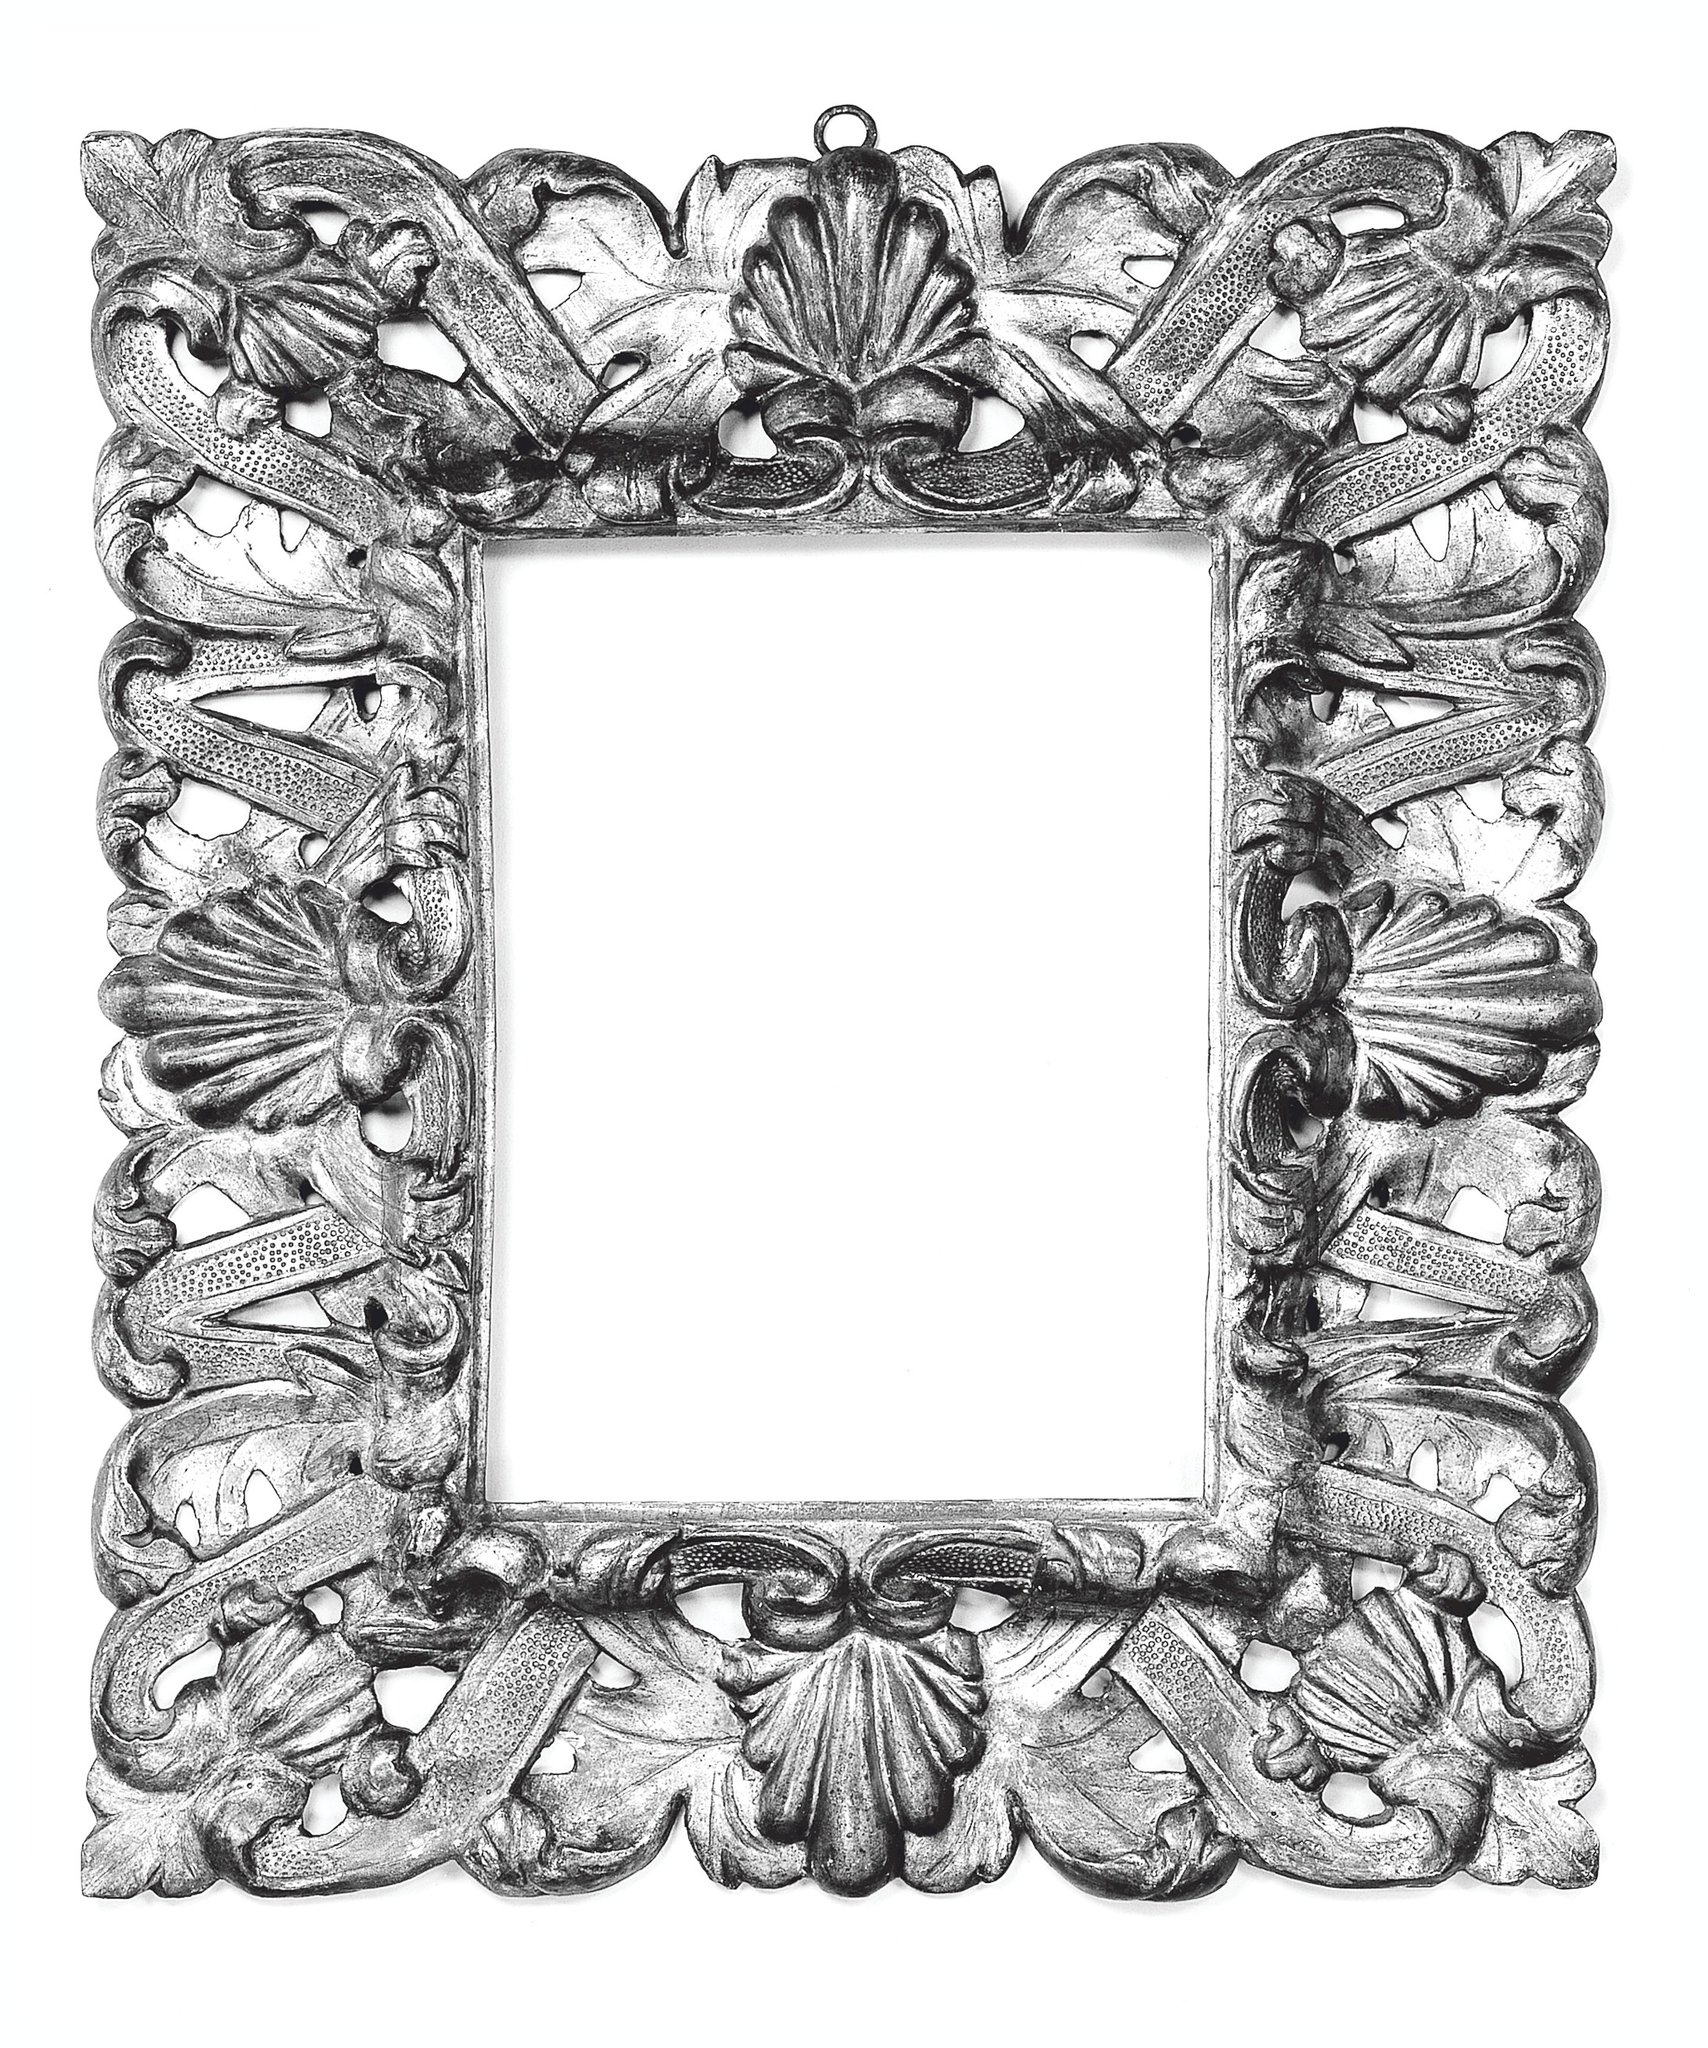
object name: frame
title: Palatina-style Salvator Rosa frame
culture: southern italian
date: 1667-1700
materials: wood